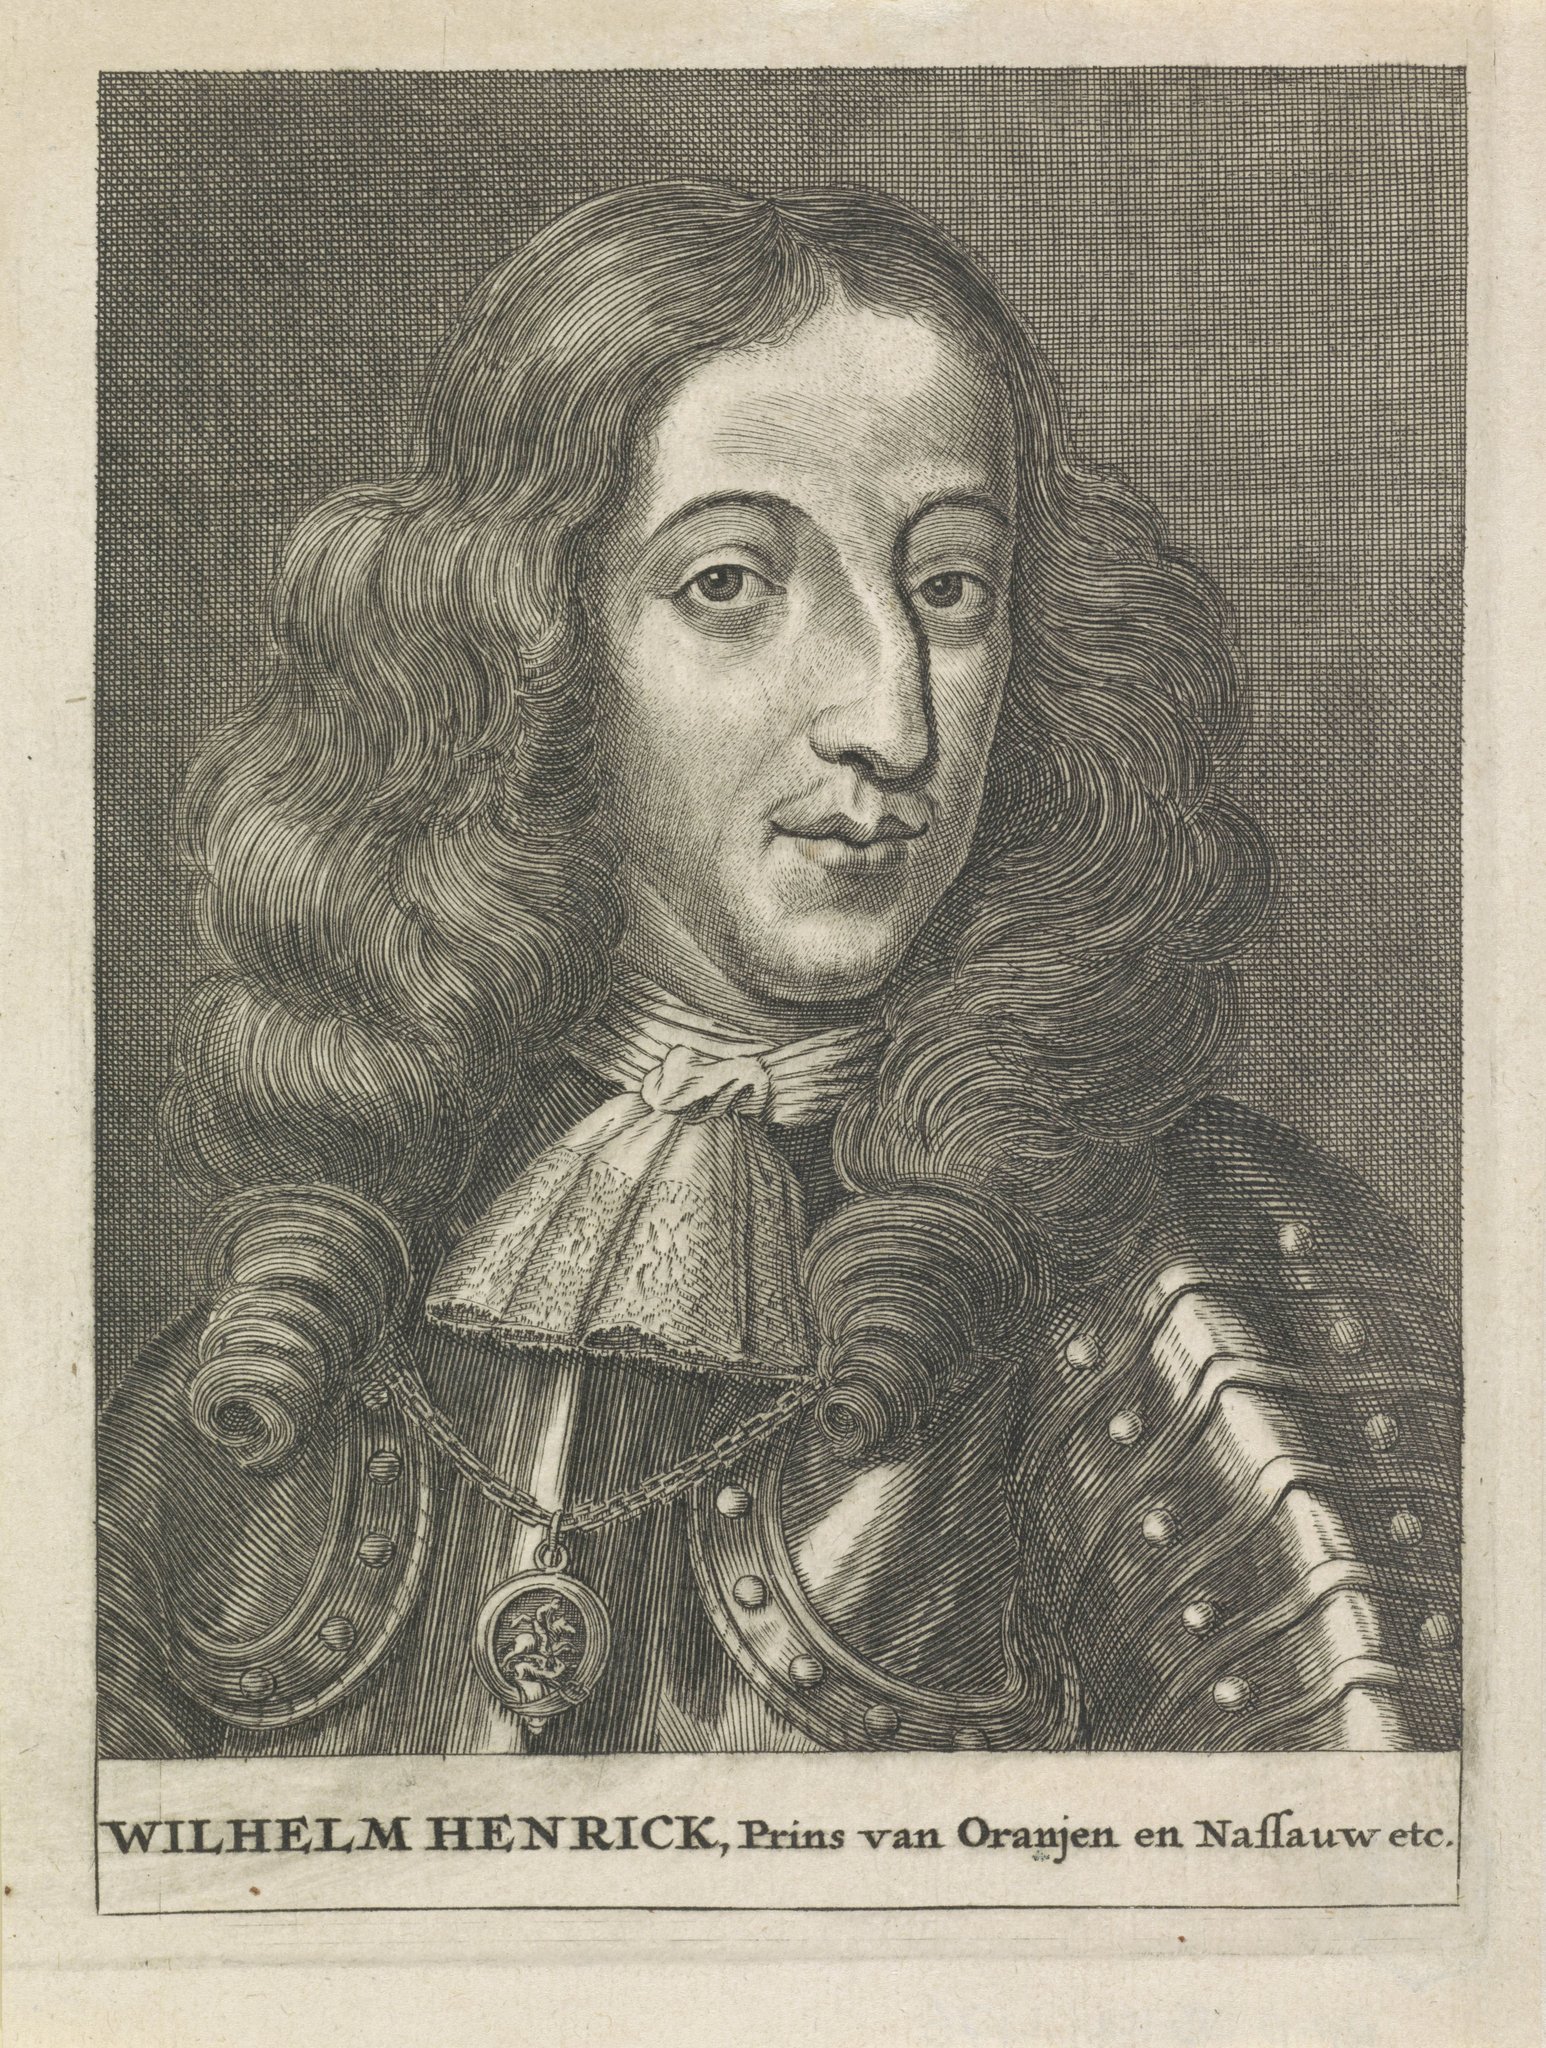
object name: print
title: Portret van Willem III, prins van Oranje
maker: Anonymous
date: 1670-1749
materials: paper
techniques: engraving, etching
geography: low countries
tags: the hague, william iii (prince of orange and king of england, scotland, and ireland), knighthood order (garter) - insignia of a knighthood order, e.g.: badge, chain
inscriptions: collector's mark: Lugt 963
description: De hier vermelde titel verwijst naar de hoogst verkregen titel van de geportretteerde, niet per se naar de titel die de geportretteerde op deze voorstelling draagt.